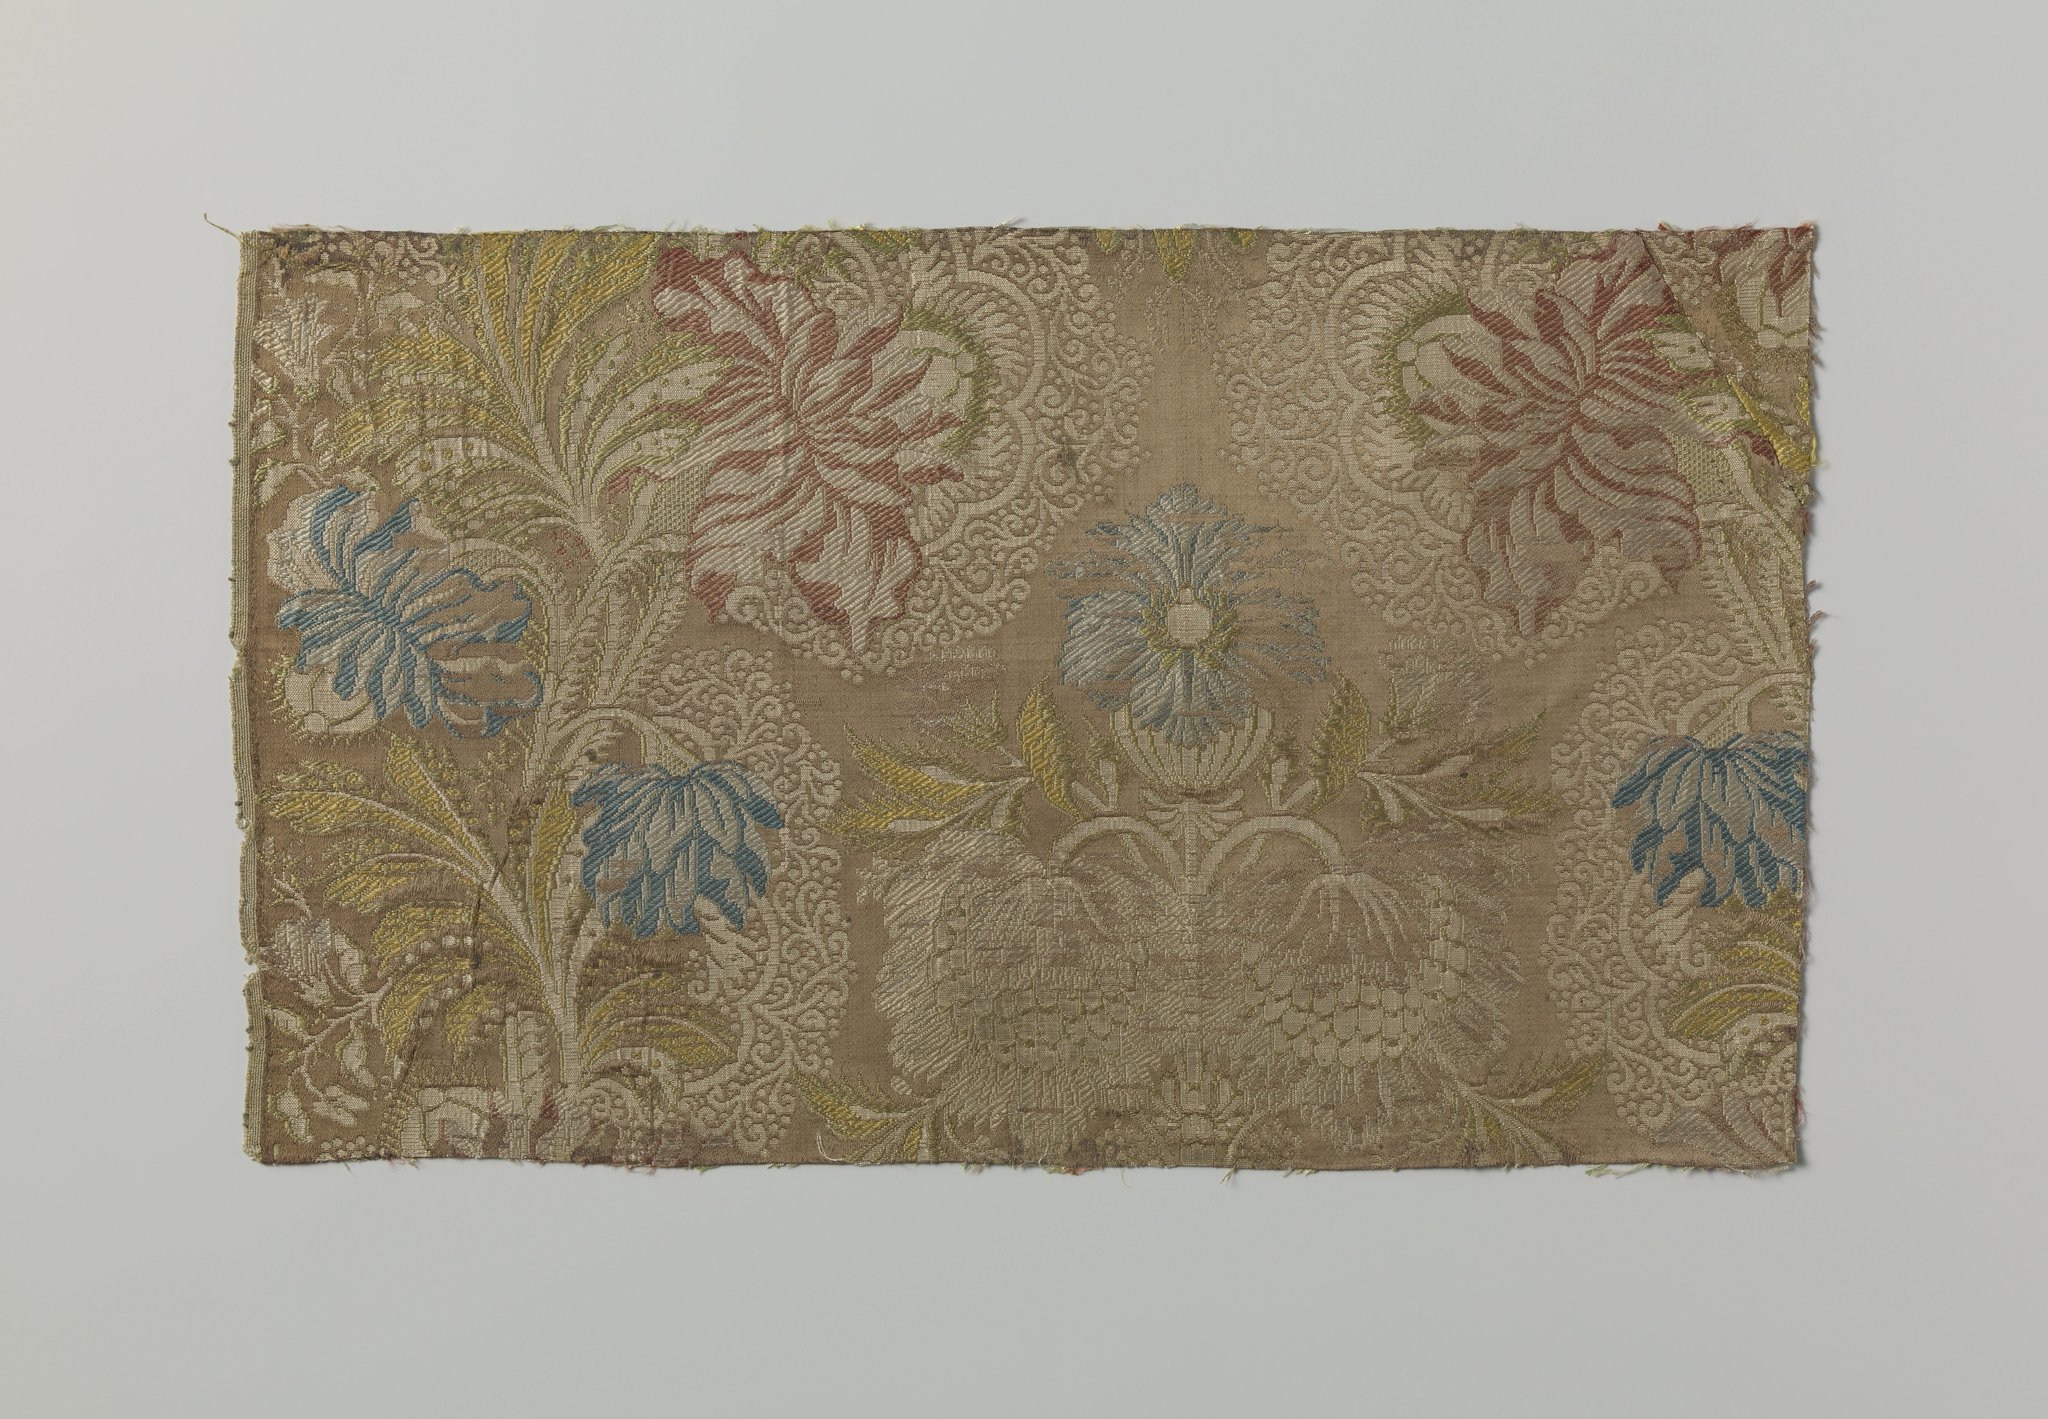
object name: fragment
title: Fragment veelkleurig, complex zijdeweefsel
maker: Anonymous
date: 1700-1725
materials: silk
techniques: brocade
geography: netherlands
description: Een fragment van licht bruin zijdeweefsel met een palmet omgeven door bloemen en kantmotief.